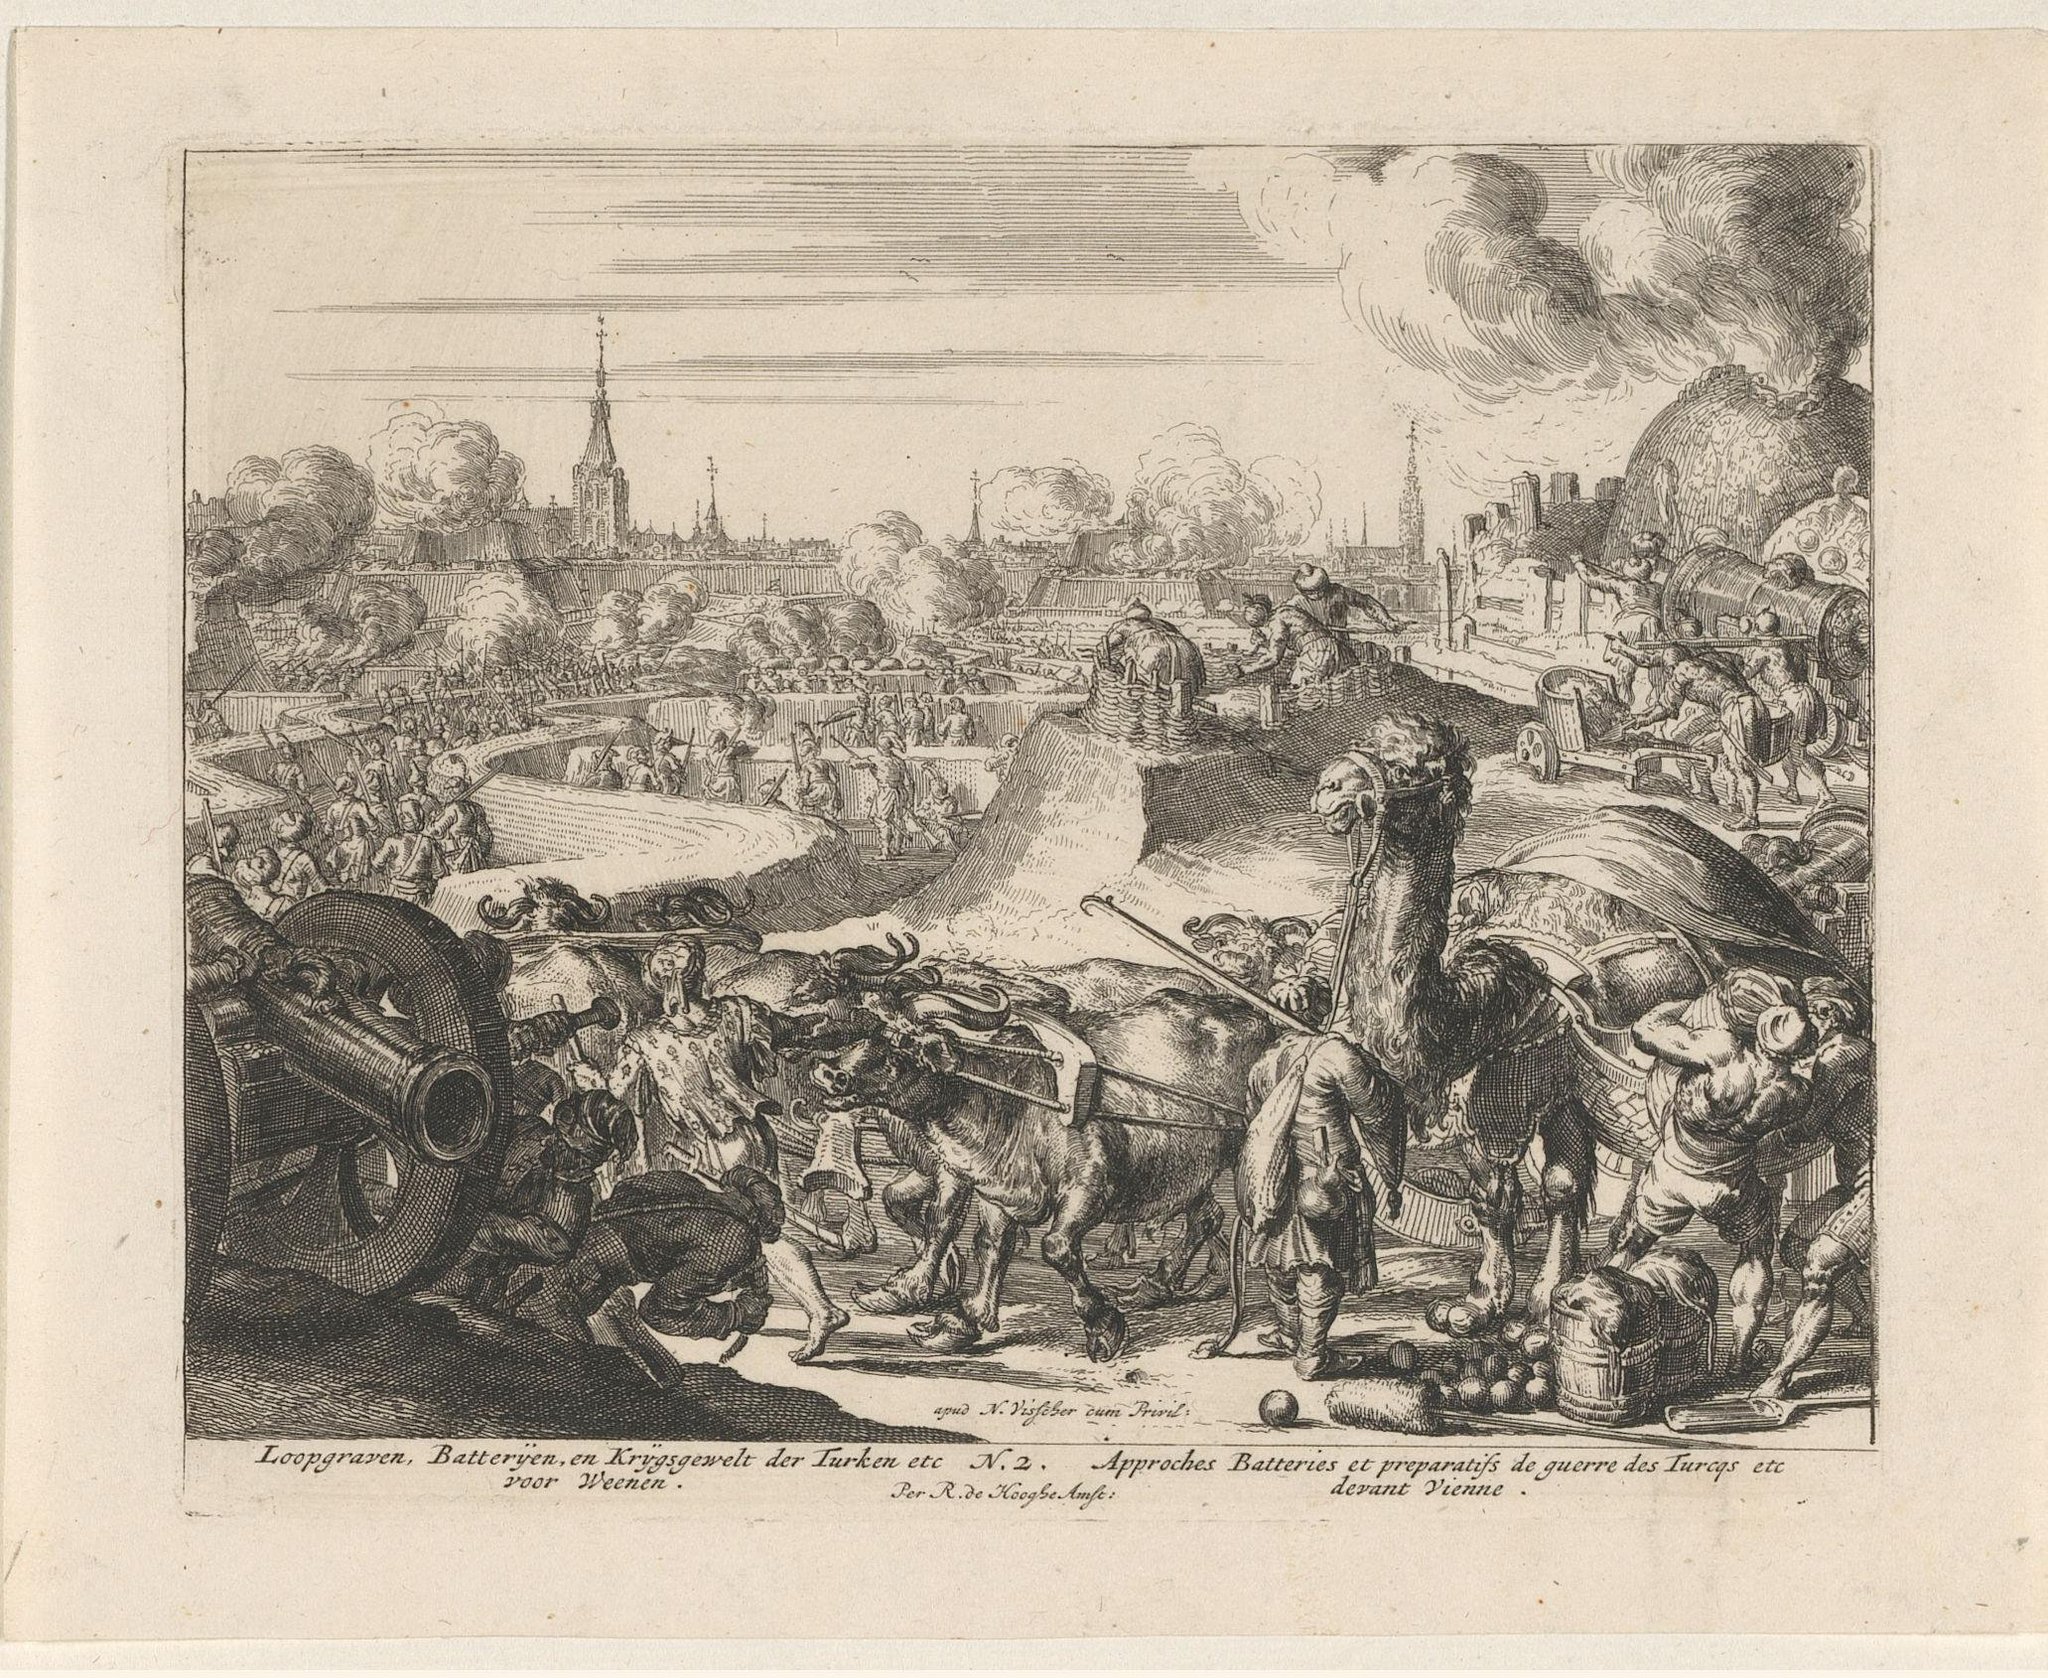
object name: print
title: Loopgraven van de Turken voor Wenen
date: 1684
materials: paper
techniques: etching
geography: amsterdam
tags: jan iii sobieski (koning van polen), leopold i (keizer van duitsland), siege, position war, trenches, vienna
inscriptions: collector's mark: Lugt 2228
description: Illustratie voor Johann van Ghelen, Relation succinte et veritable de tout ce qui s'est passé pendant le siege de Vienne, residence de Sa Majesté Imperiale, assiegée par les Turcs depuis le 14. juillet jusqu'au 12. de septembre 1683., Bruxelles: Jean Leonard, 1684.